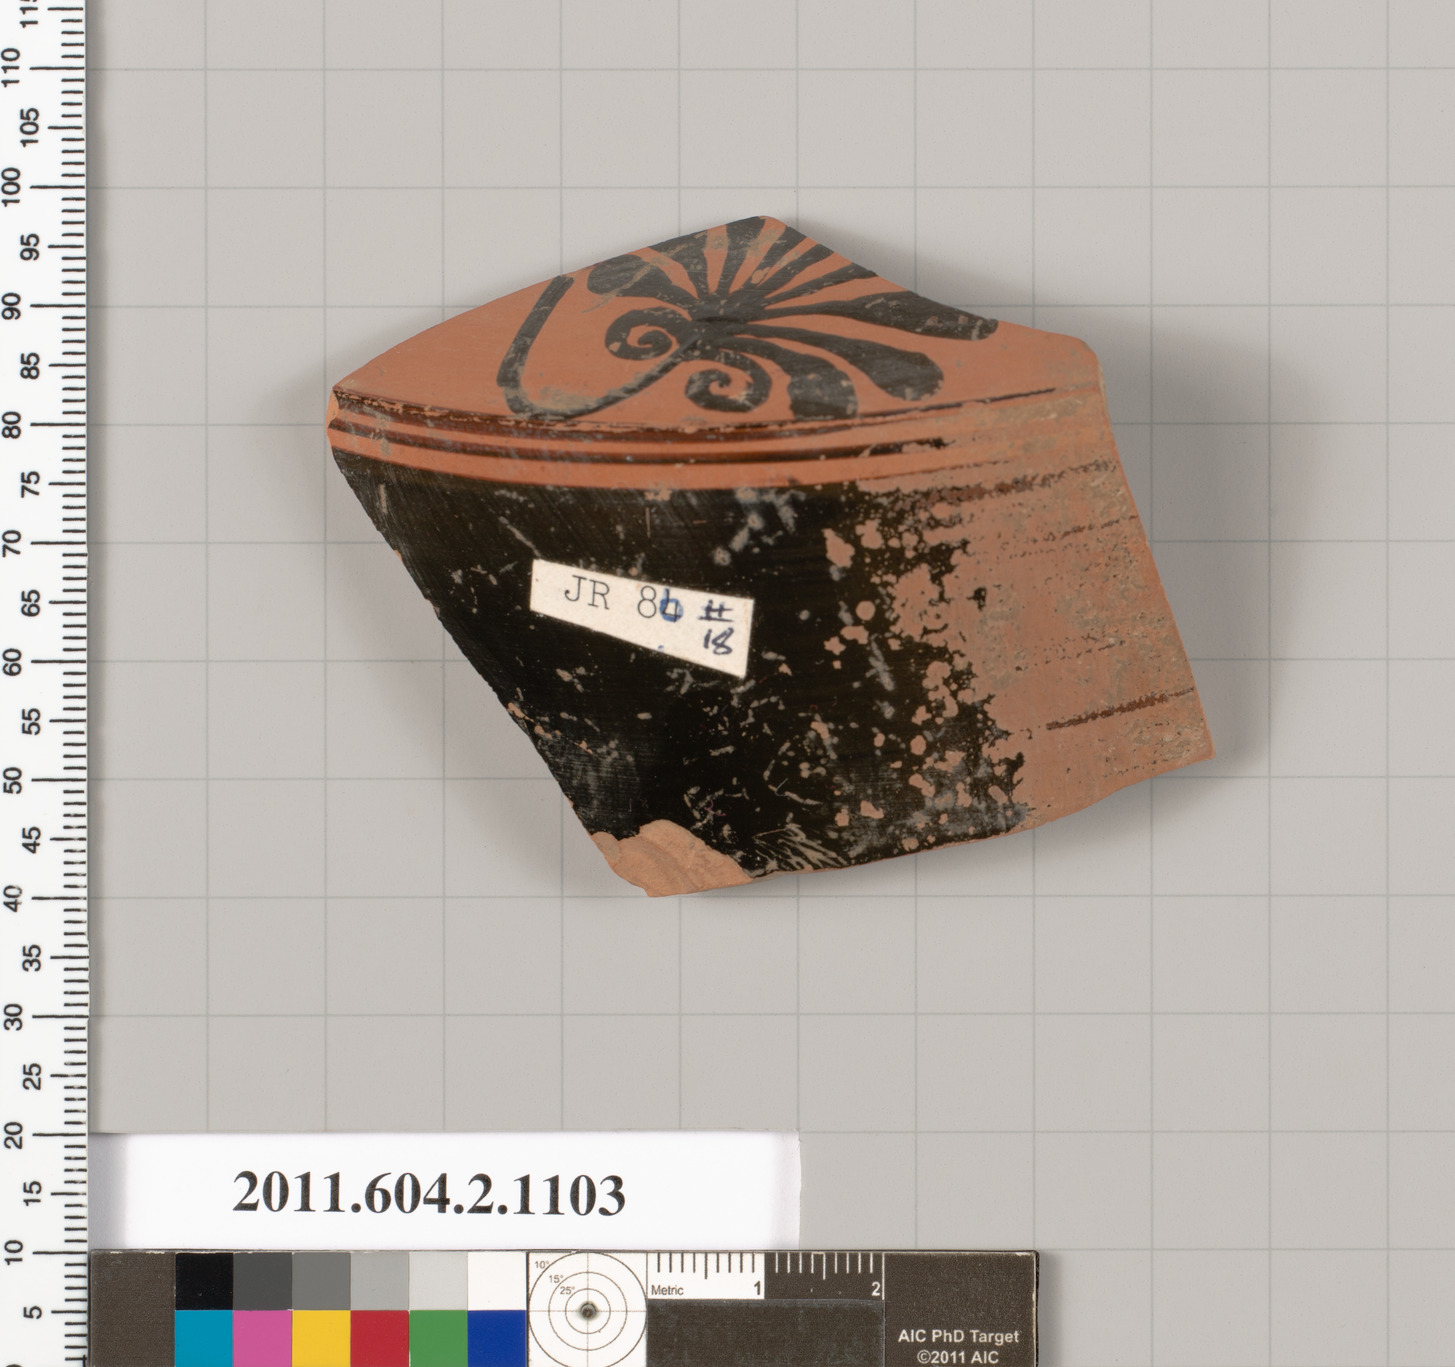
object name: lekythos fragment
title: Terracotta fragment of a lekythos (oil flask)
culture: greek, attic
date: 500-480 BCE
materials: terracotta